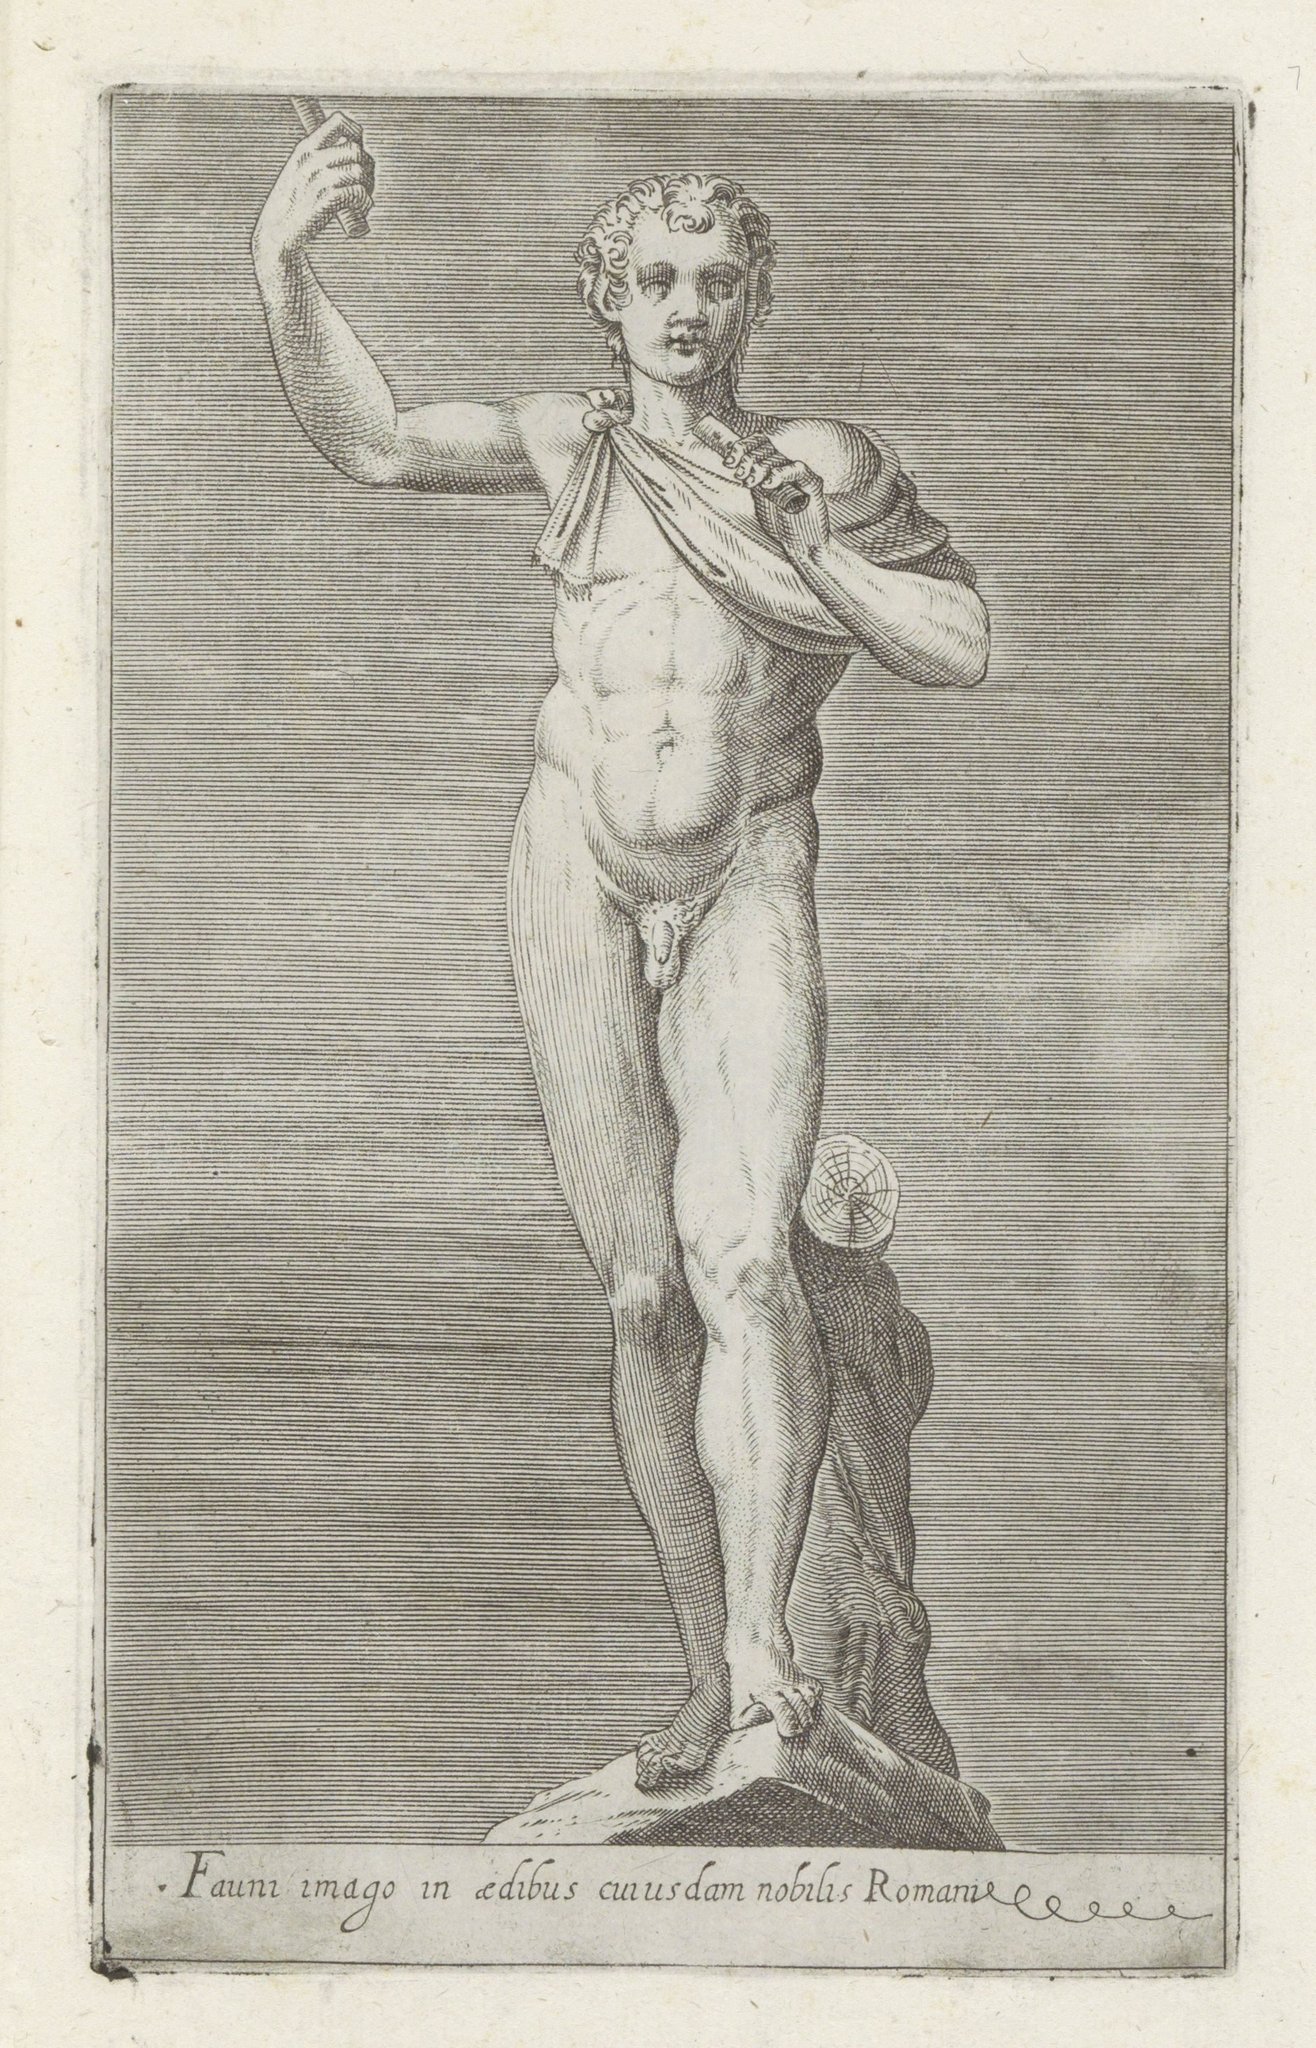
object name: album leaf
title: Fauni imago in aedibus cuiusdam nobilis Romani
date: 1584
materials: paper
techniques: engraving, intaglio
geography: italy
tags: satyrs, fauns, sileni, piece of sculpture, reproduction of a piece of sculpture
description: Deze prent maakt deel uit van een set van 79 prenten (+ titelprent) met voorstellingen van antieke sculpturen in Rome.